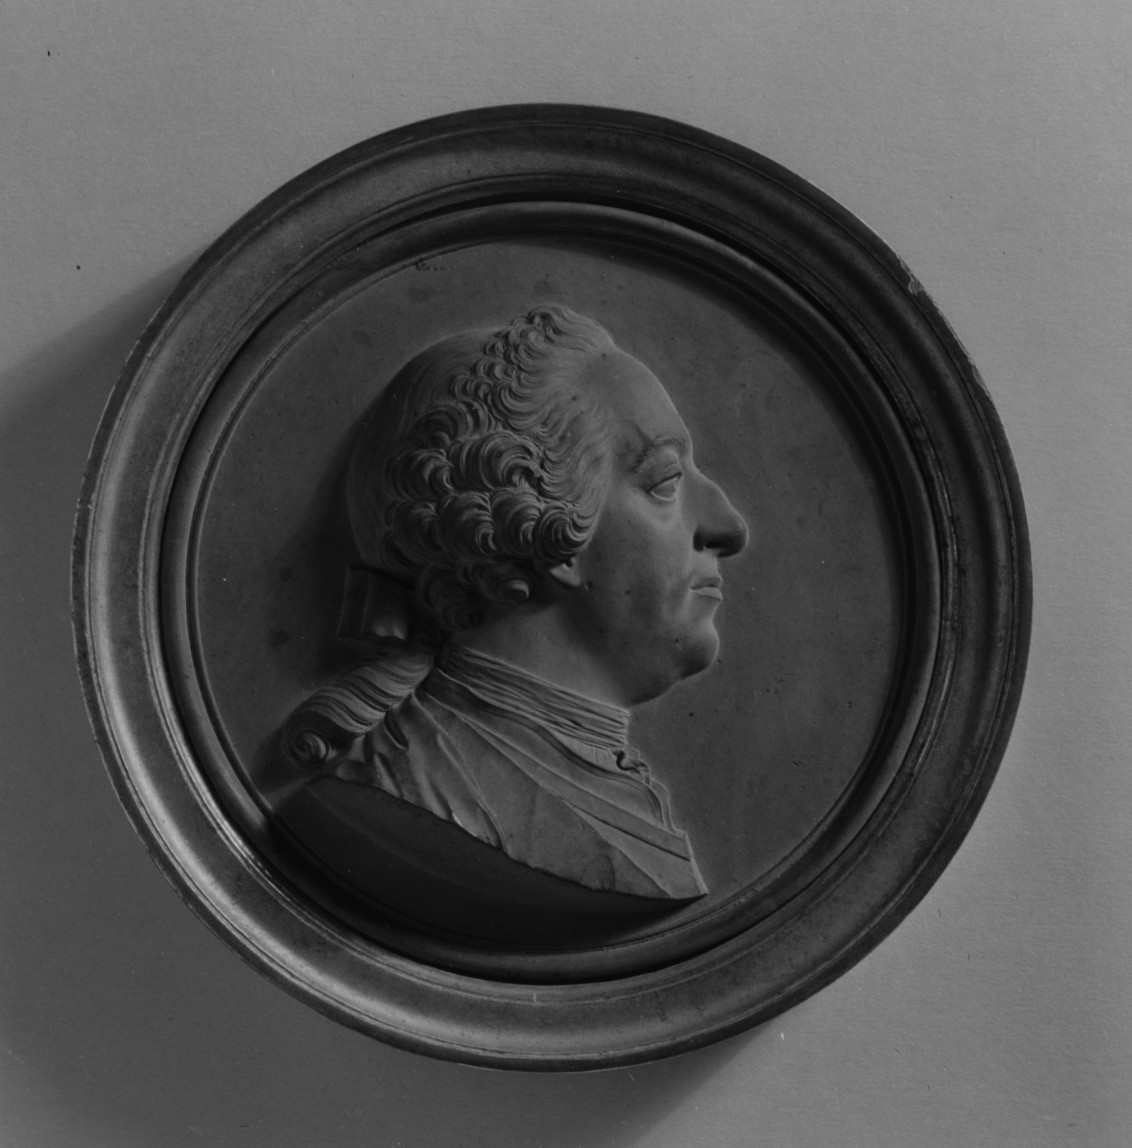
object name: medallion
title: Louis XV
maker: jean-baptiste nini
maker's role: artist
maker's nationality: italian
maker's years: 1717-1786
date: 1763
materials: gilt, terracotta, wood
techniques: casting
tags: men,profiles